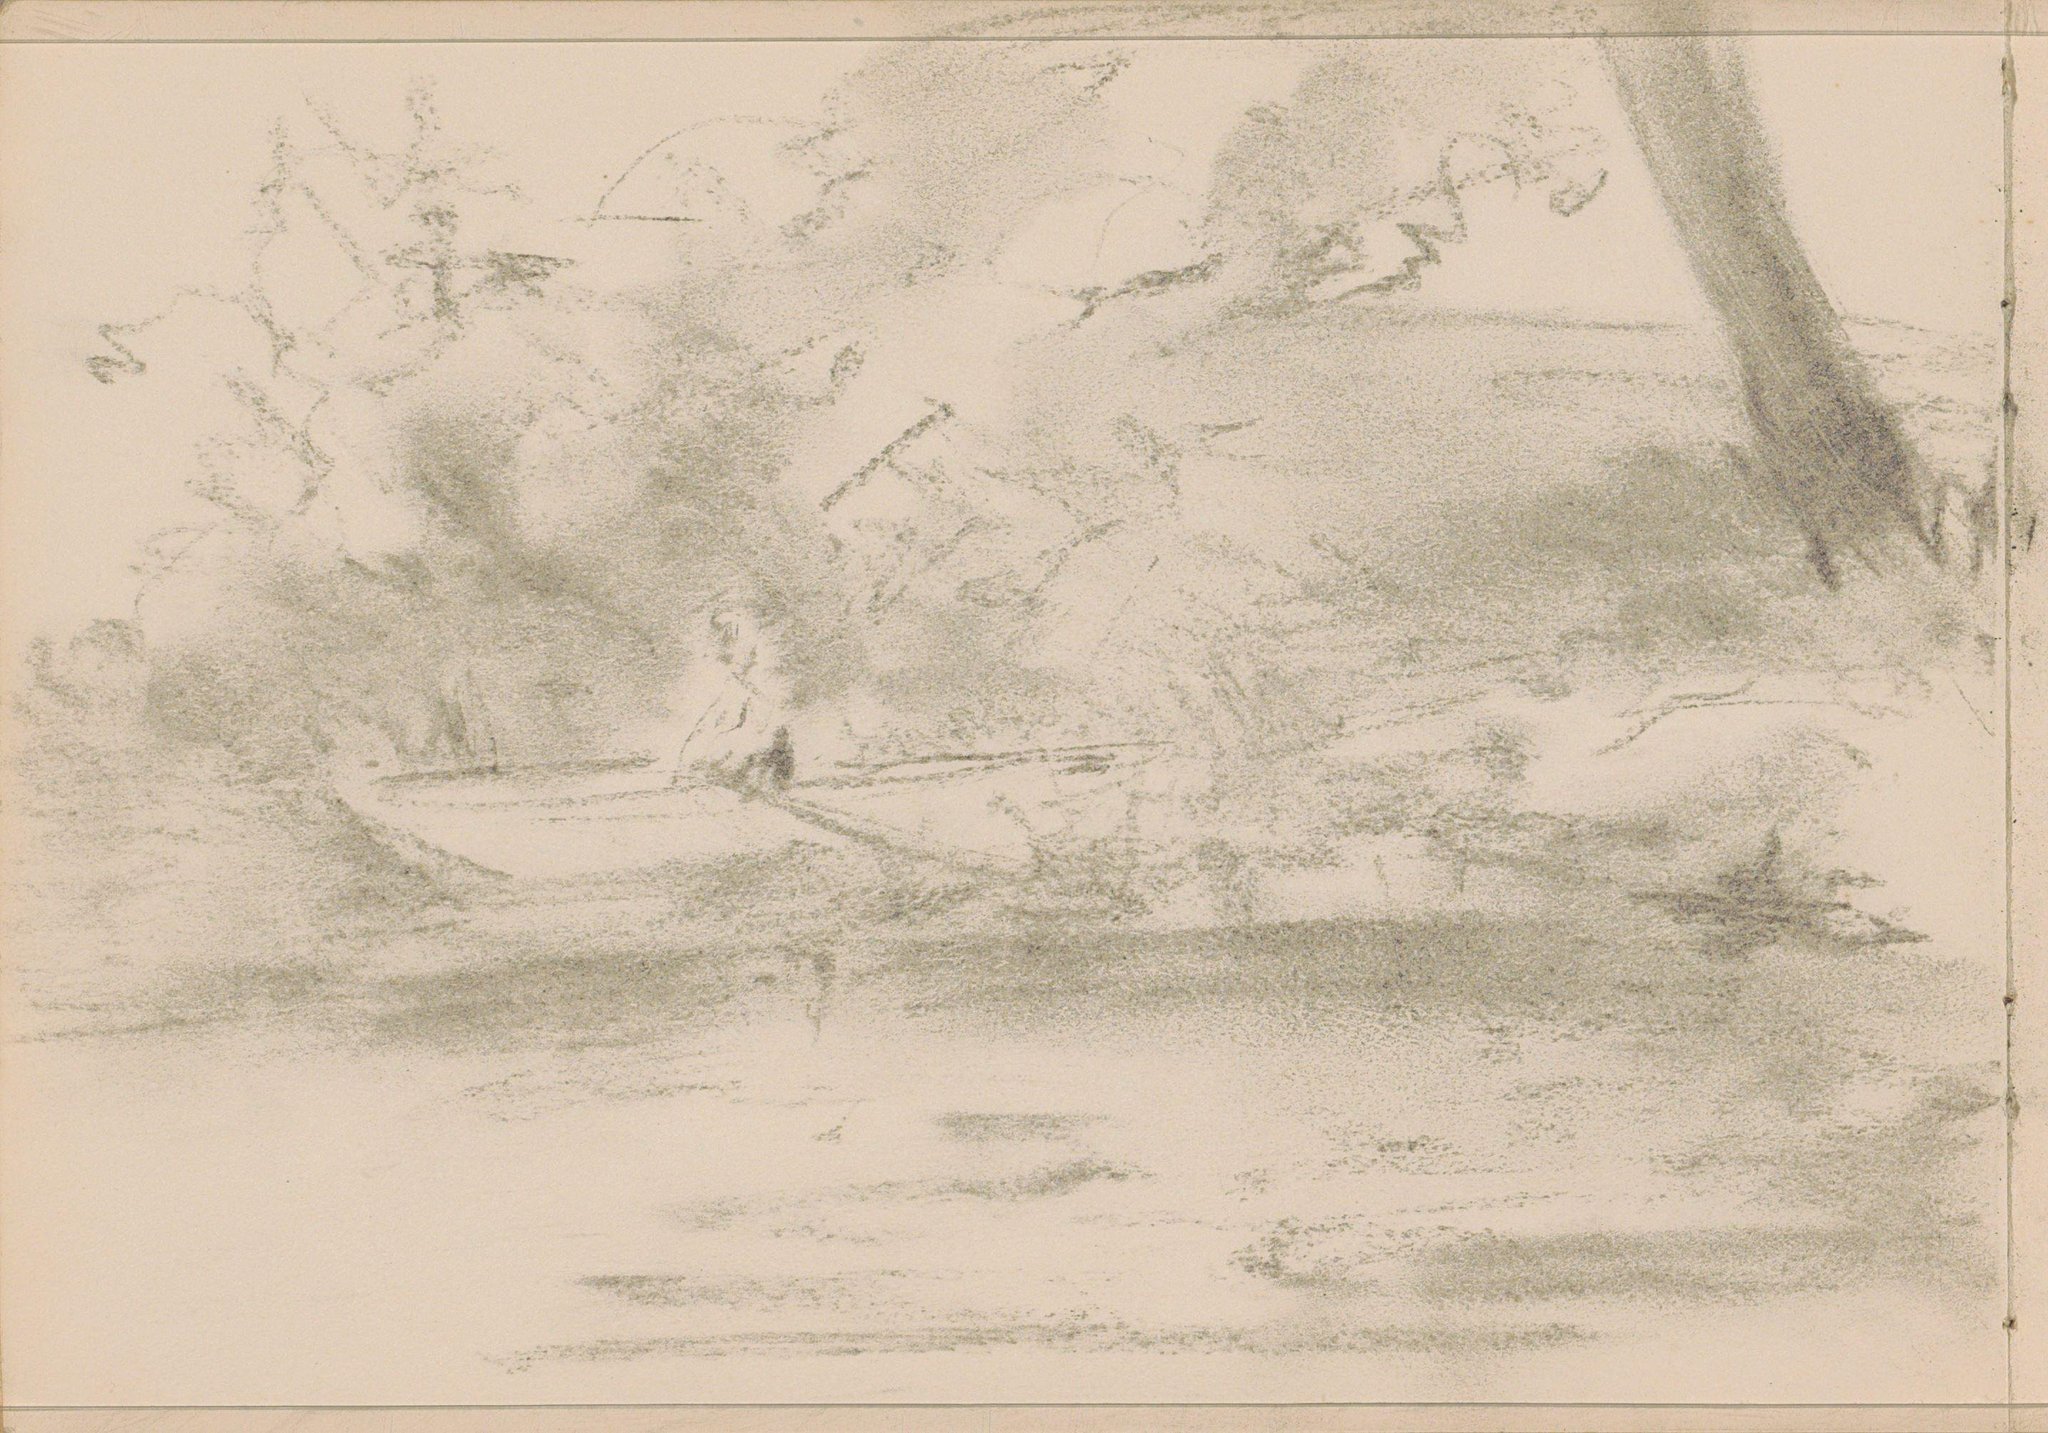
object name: sketchbook leaf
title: Rivier met een figuur in een roeiboot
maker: a.a.l. de grammont-hubrecht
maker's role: draughtsman, painter, print maker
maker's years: 1855-1913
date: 1865-1913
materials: charcoal, paper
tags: sitting figure, river, rowing-boat, canoe, etc.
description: Blad 66 verso uit een schetsboek met 68 bladen.